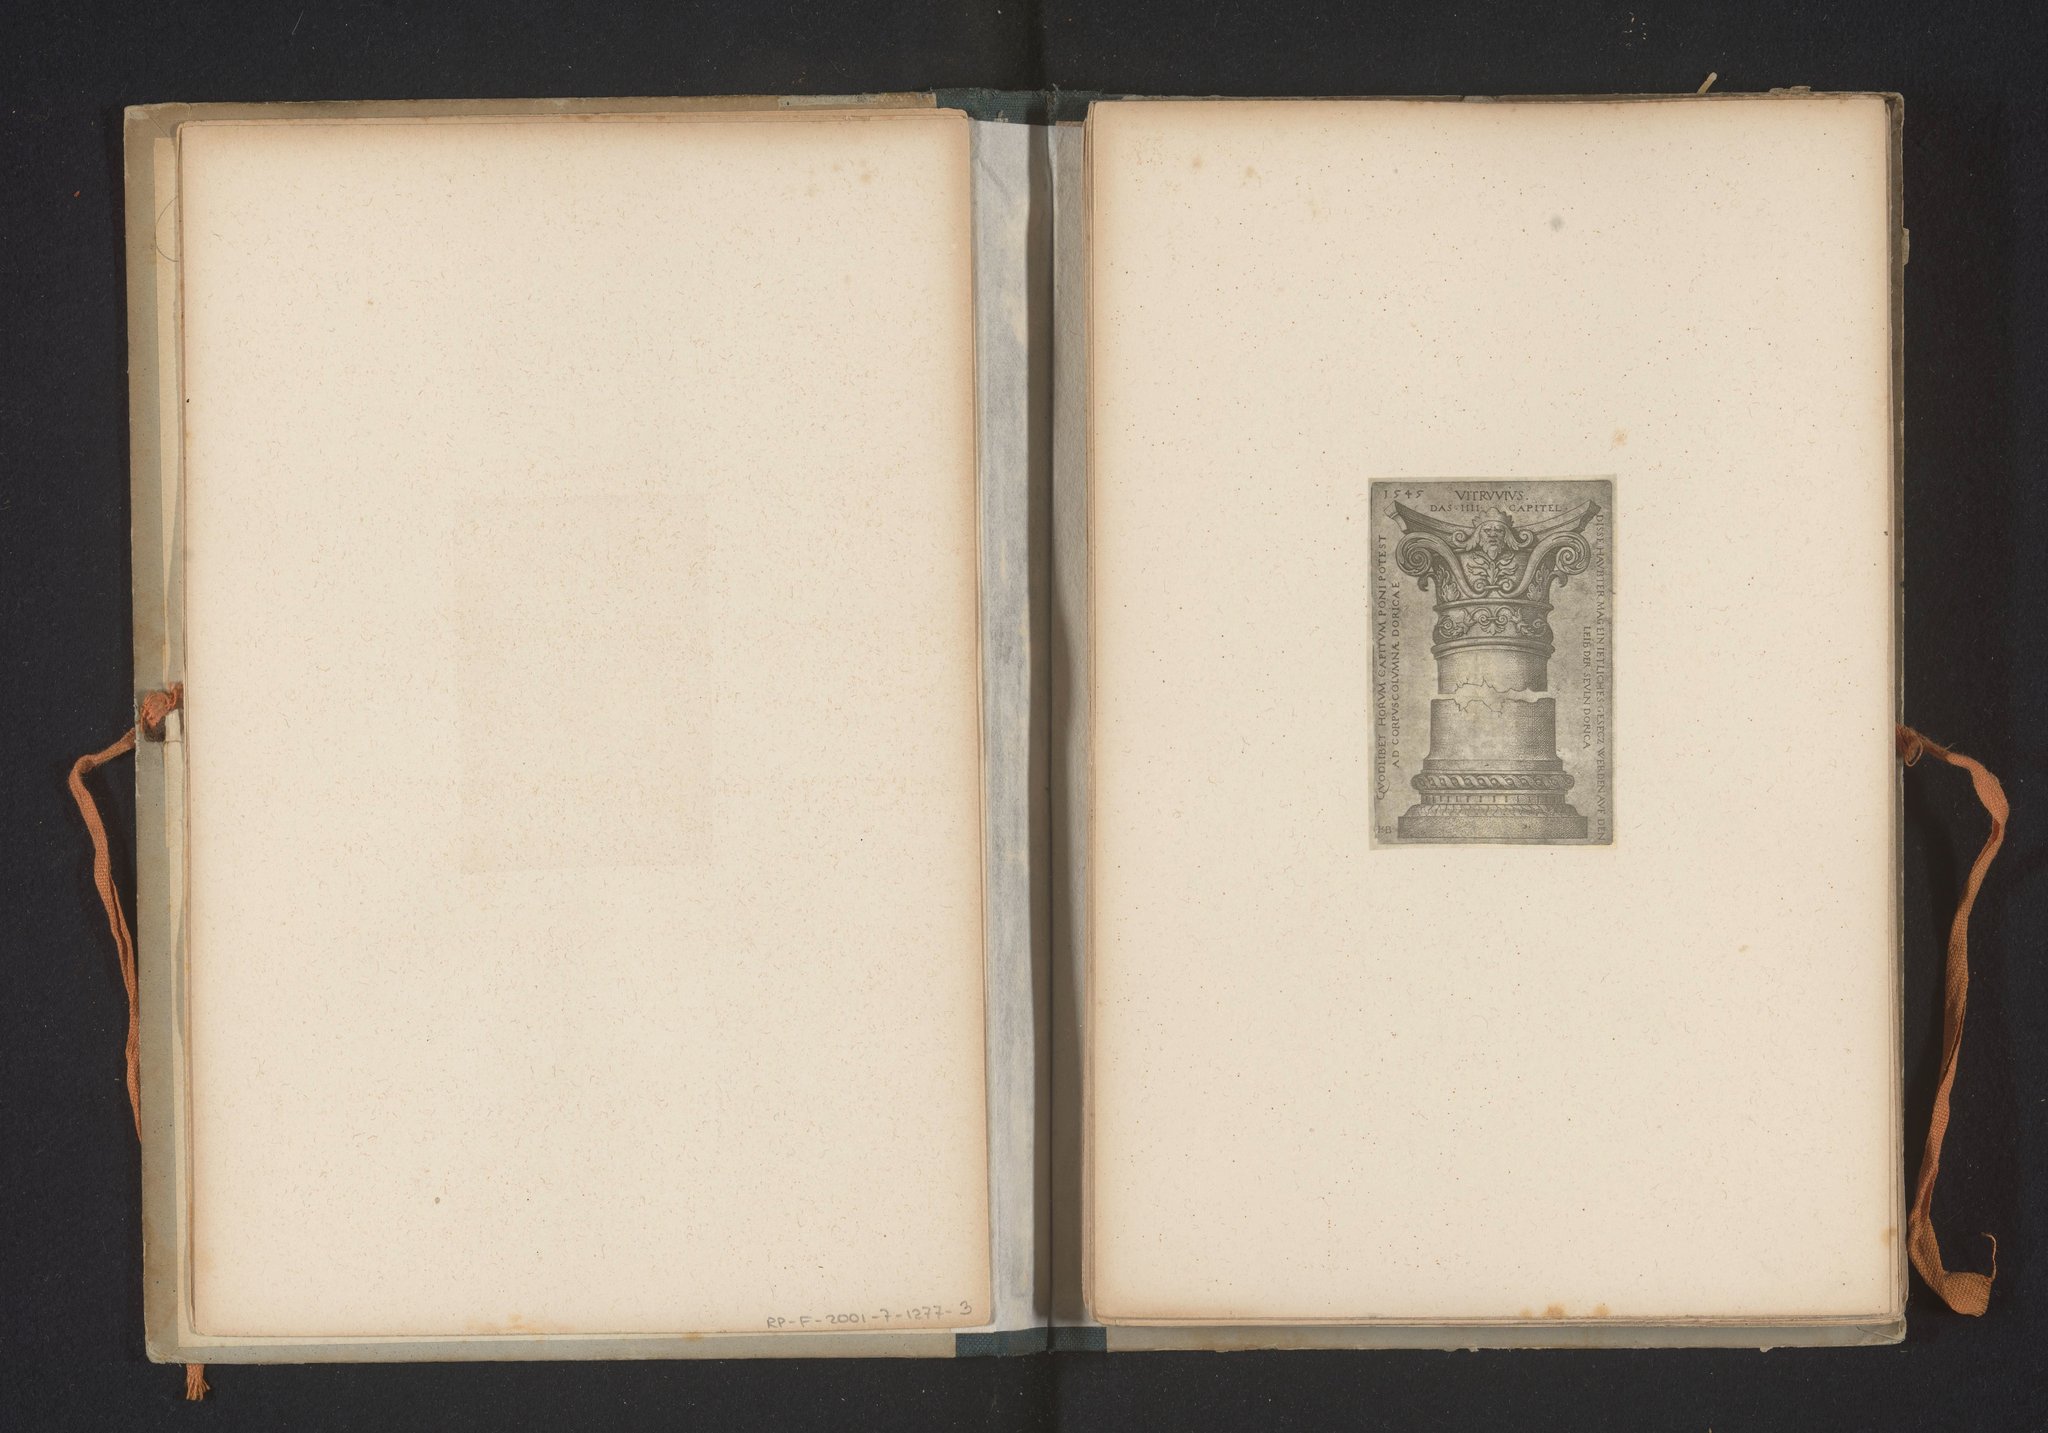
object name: reproduction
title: Reproductie van een prent van een Dorische pilaar door Hans Sebald Beham naar Vitruvius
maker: hans sebald beham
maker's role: designer, draughtsman, print maker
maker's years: 1500-1550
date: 1866-1871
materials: paper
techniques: woodburytype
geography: brussels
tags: column, pillar ~ architecture, doric order ~ architecture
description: Deze prent maakt deel uit van een omslag met 57 prenten op 54 bladen.